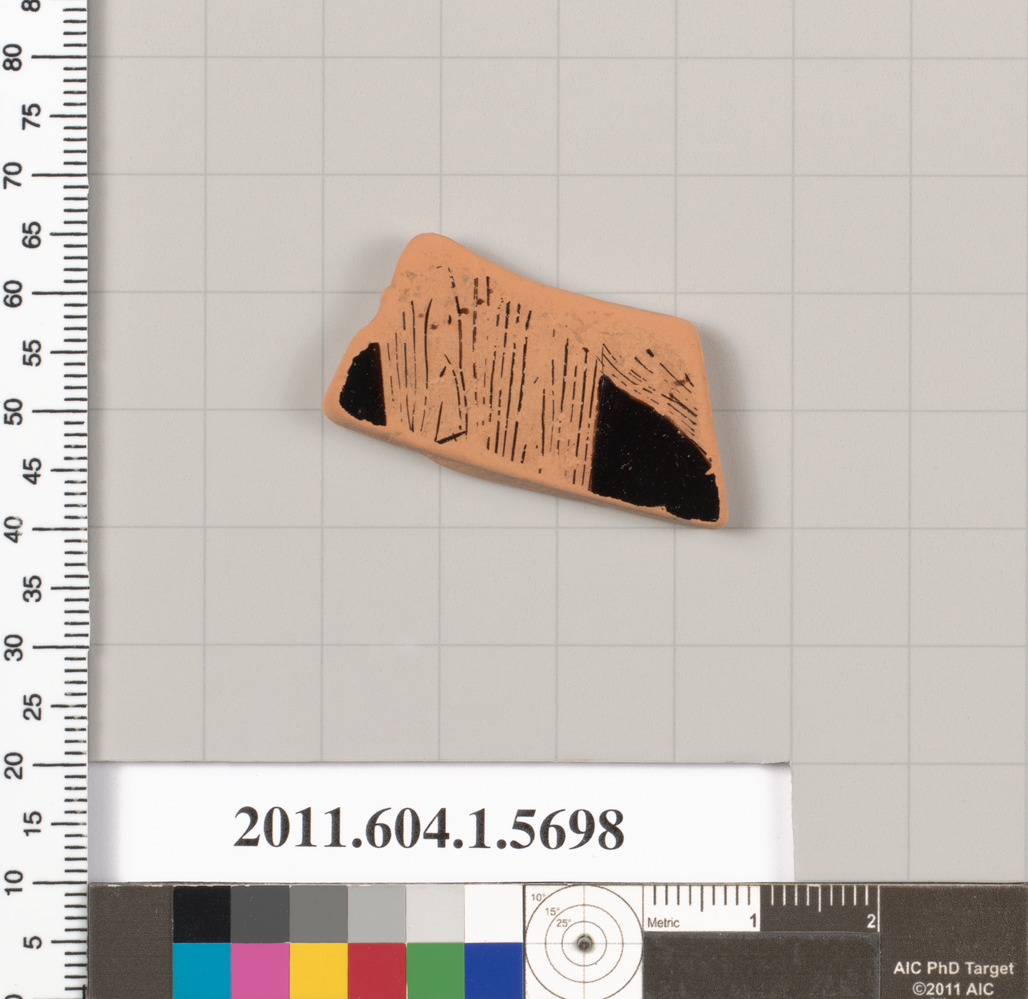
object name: kylix fragment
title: Terracotta fragment of a kylix (drinking cup)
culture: greek, attic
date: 490-480 BCE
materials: terracotta